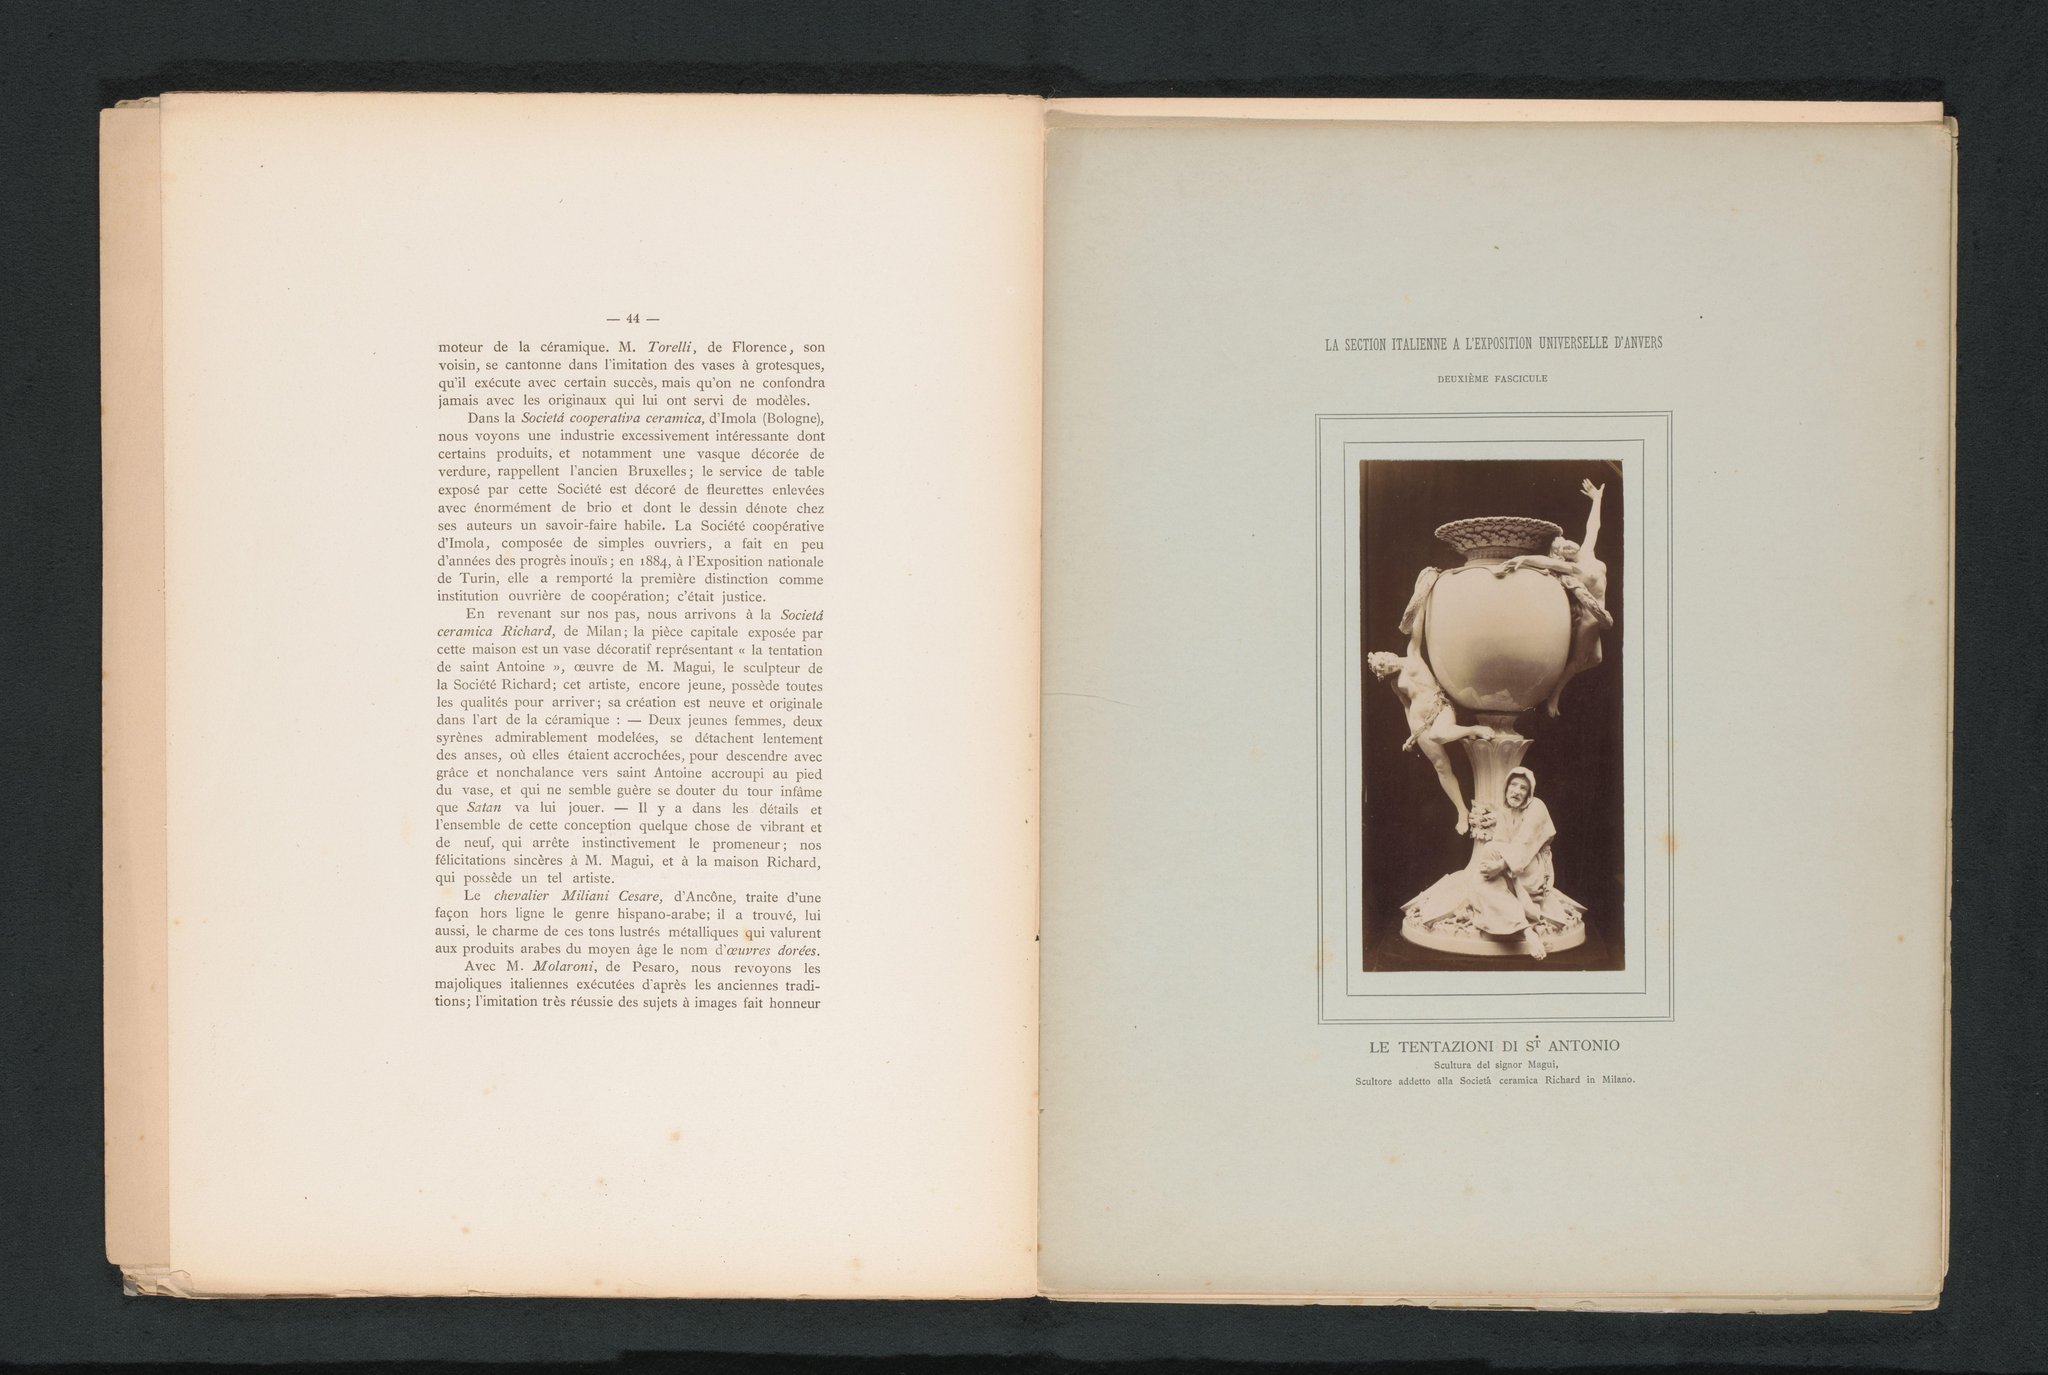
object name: page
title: Sculptuur van de verzoeking van de heilige Antonius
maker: Anonymous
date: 1880-1885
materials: photographic support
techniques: albumen print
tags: piece of sculpture, reproduction of a piece of sculpture, the franciscan monk antony of padua; possible attributes: ass, book, crucifix, flowered cross, flaming heart, infant christ (on book), lily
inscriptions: inscription: ‘Scultura del signor Magui,/ Scultore addetto alla Societá ceramica Richard in Milano.’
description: Foto op losse plaat tegenover pagina 44.